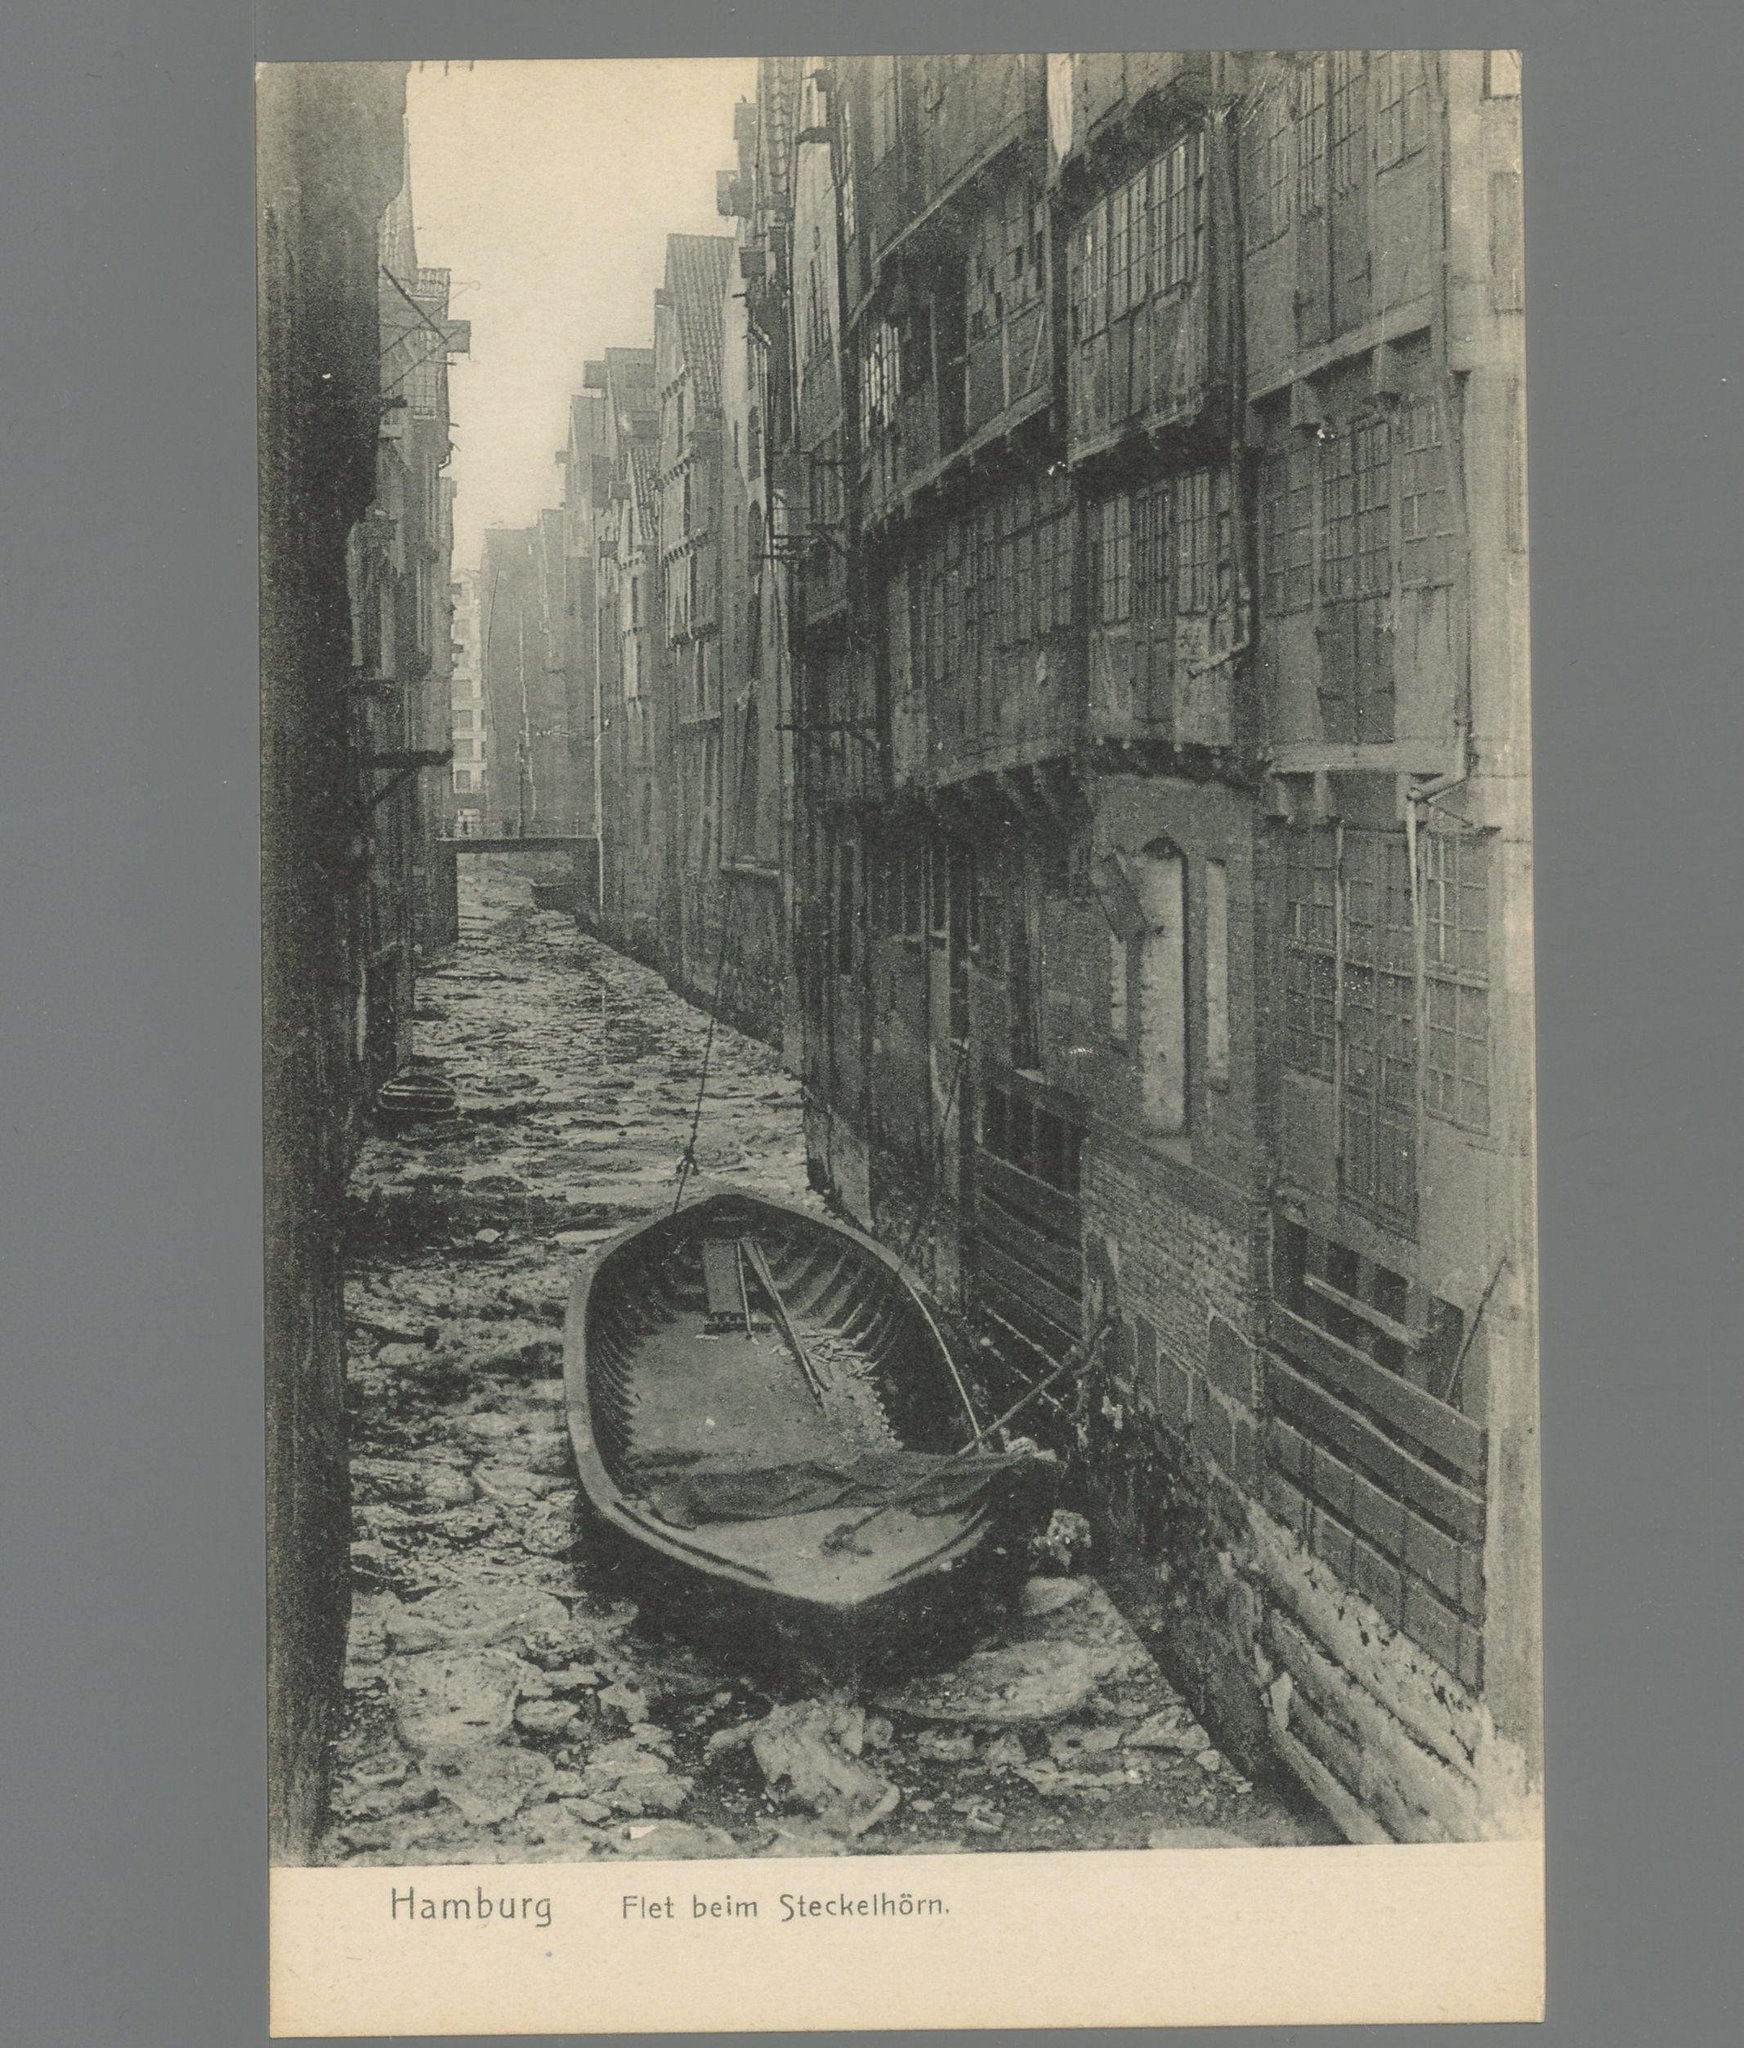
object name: ansichtkaart, prentbriefkaart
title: Hamburg. Flet beim Steckelhörn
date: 1906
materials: cardboard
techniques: photograph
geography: hamburg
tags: canals, waters (in city), street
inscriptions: date